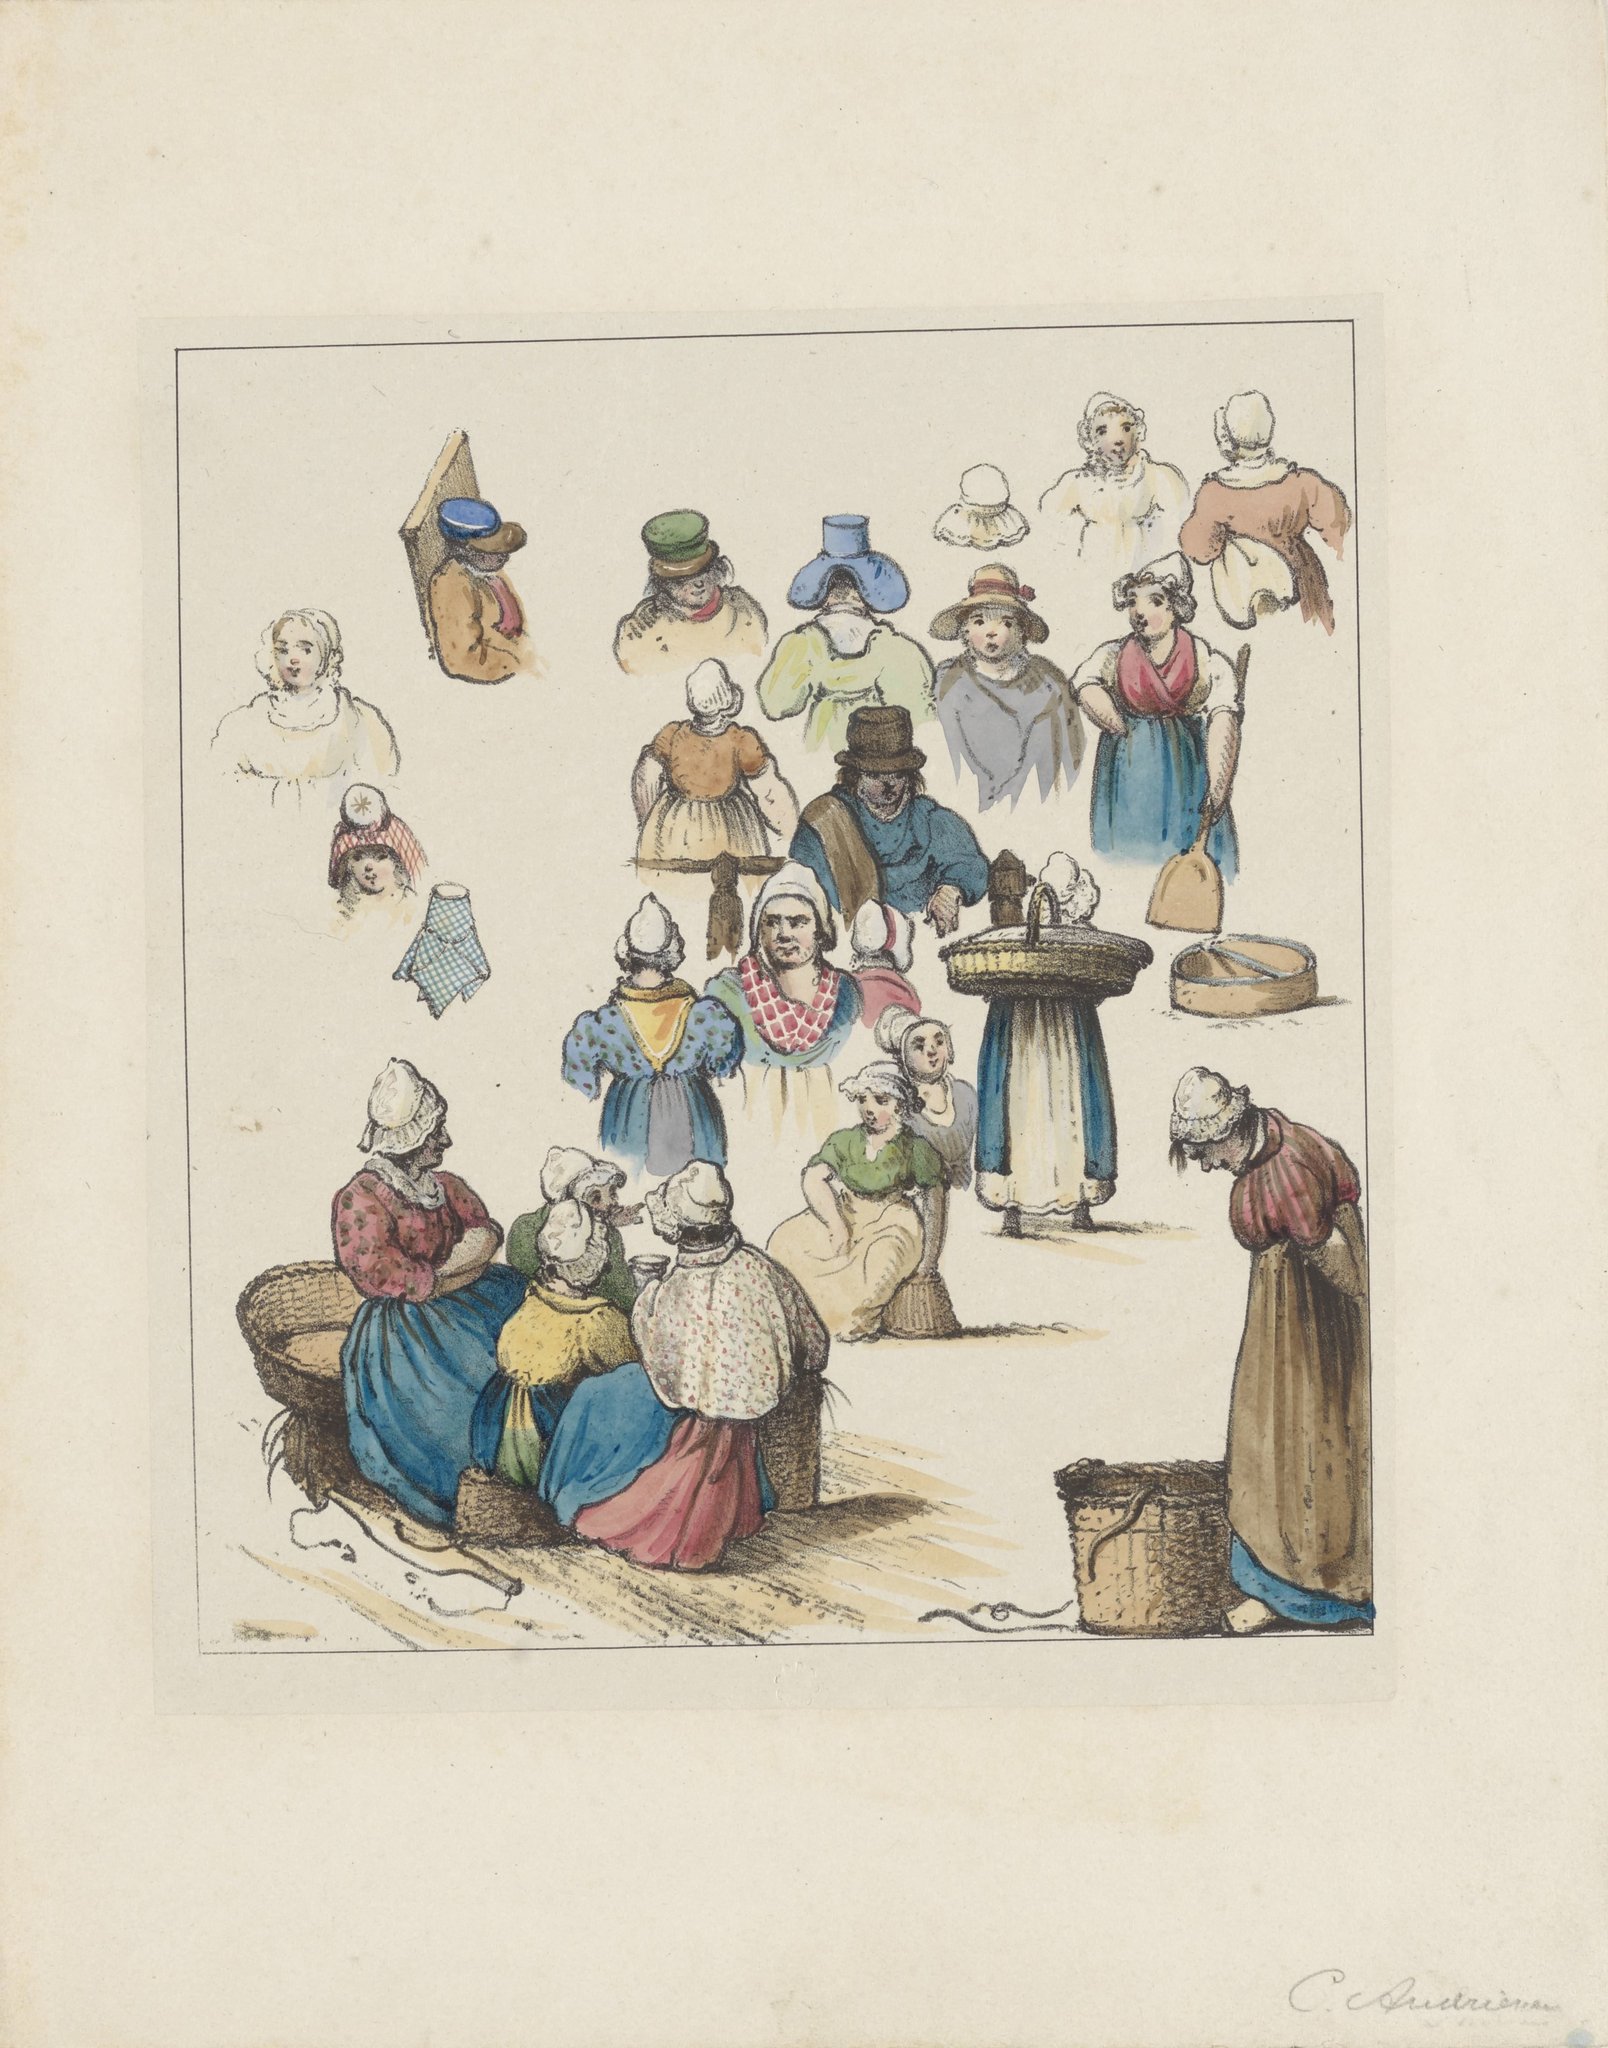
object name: print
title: Figuurstudies (derde blad), 1833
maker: christiaan andriessen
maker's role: draughtsman, print maker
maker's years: 1775-1846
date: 1833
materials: paper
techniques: hand coloring, lithograph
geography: amsterdam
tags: street-trader, folk costume, regional costume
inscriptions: collector's mark: Lugt 2228, collector's mark:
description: Blad met figuren: linksonder een groep vrouwen zittend op en bij manden, rechtsonder een staande vrouw bij een mand met palingen. Onderdeel van een serie van zes bladen met figuurstudies van Nederlandse klederdrachten, straatfiguren en gebuiken, 1833.